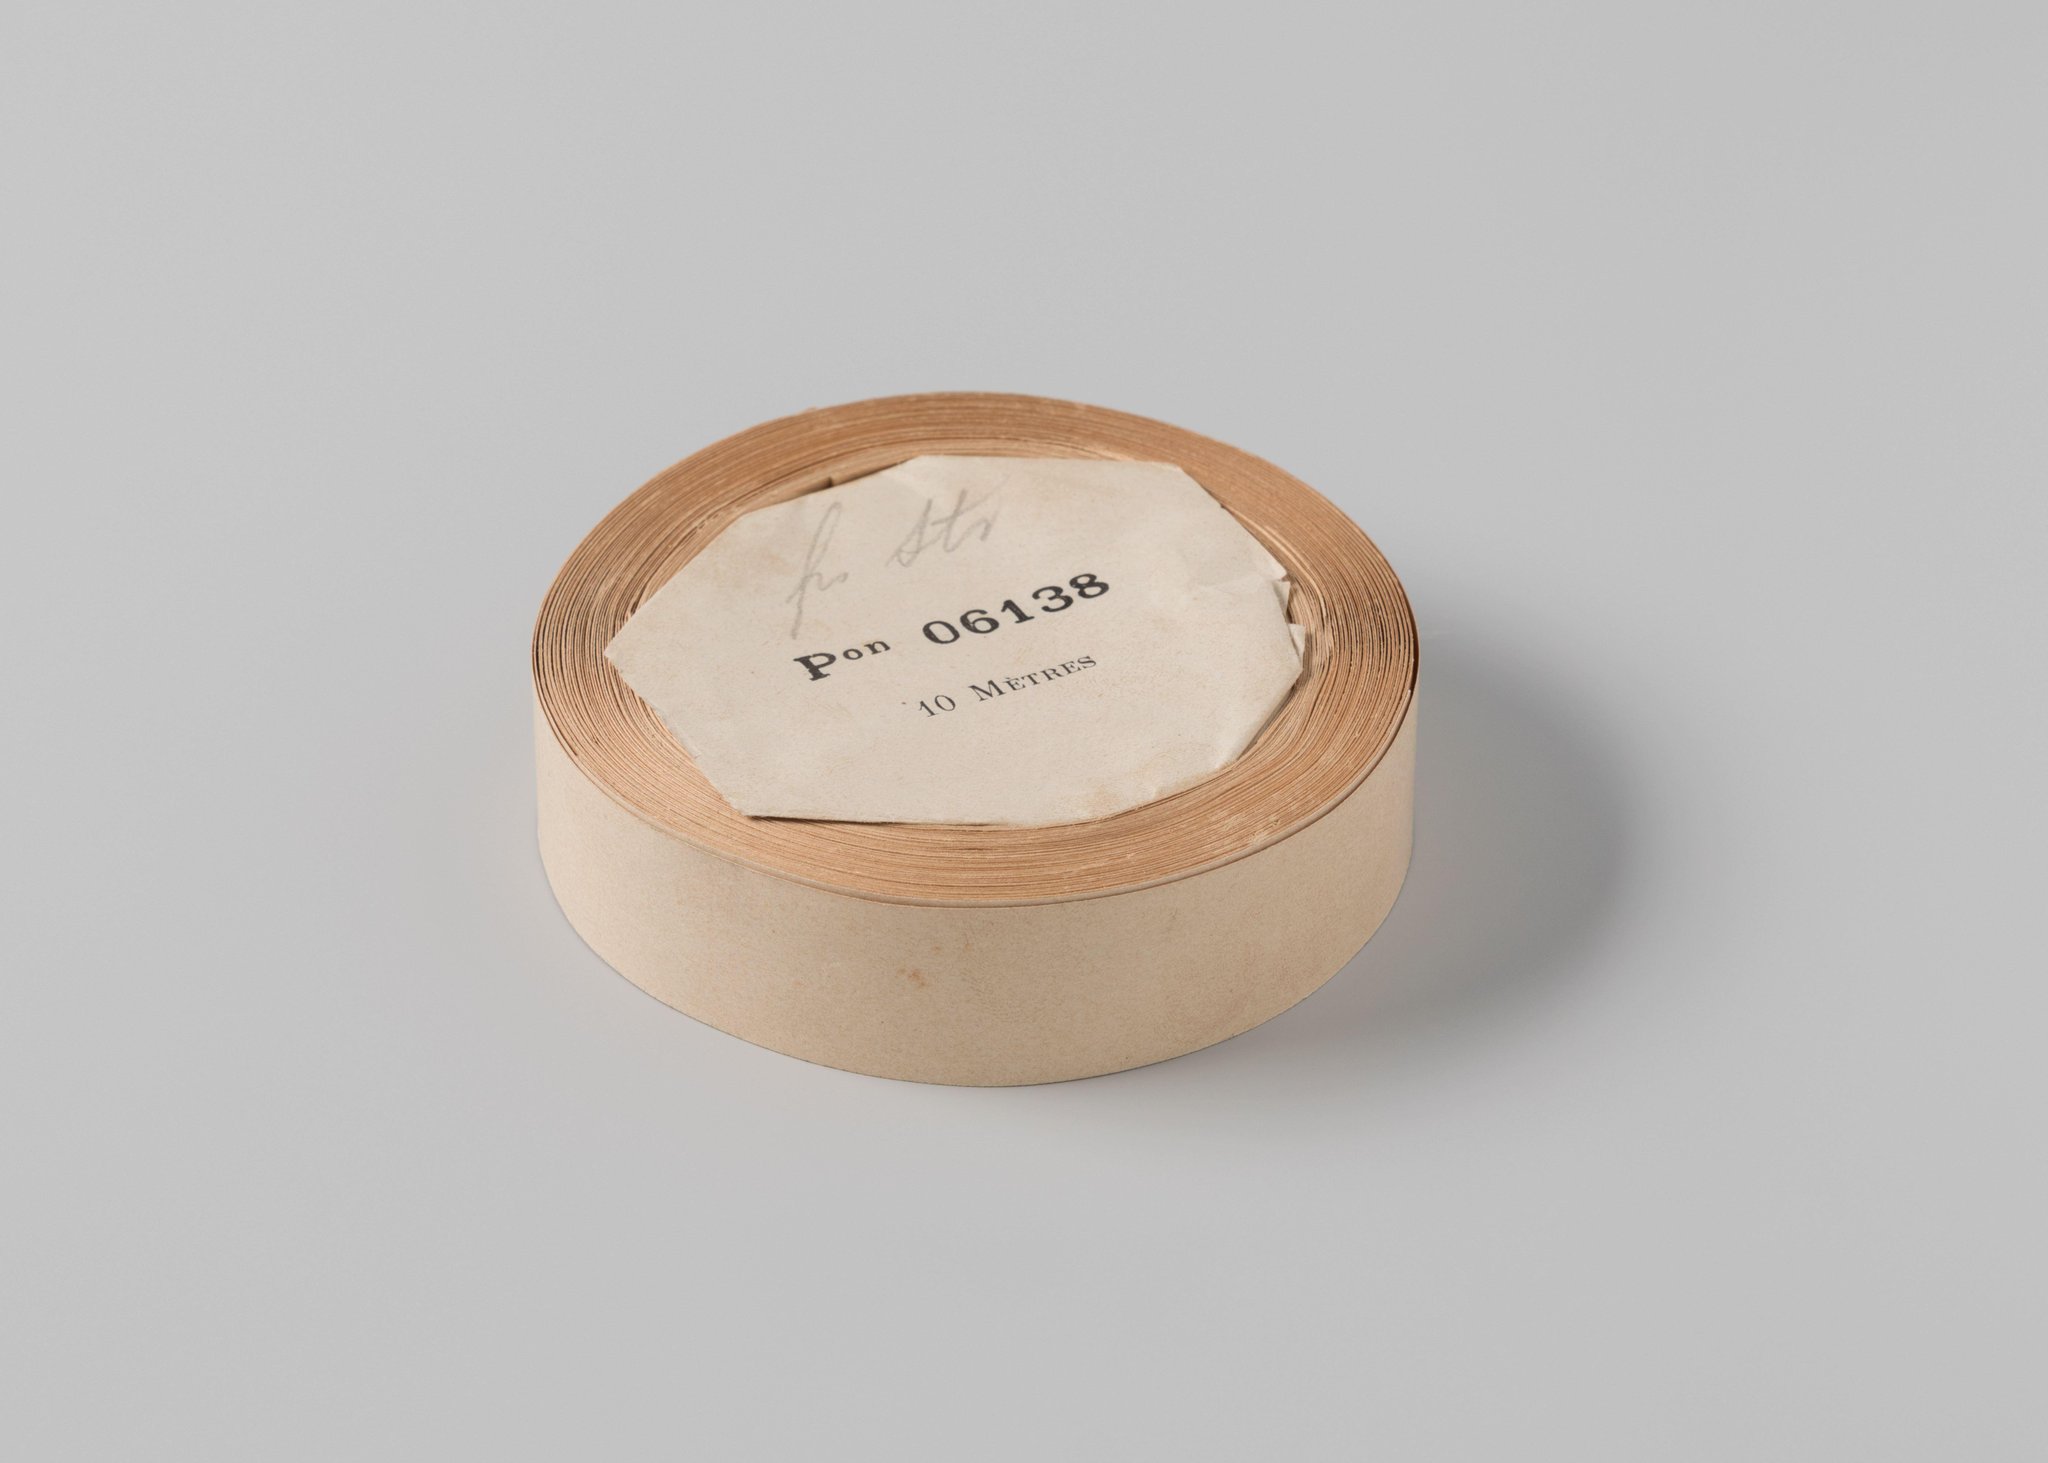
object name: ribbon material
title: Rol met wit lint met één gerafelde zijde en drie zwarte horizontale strepen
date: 1930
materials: cardboard, paper, textile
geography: nijmegen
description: Rol met wit lint met één gerafelde zijde en drie zwarte horizontale strepen.